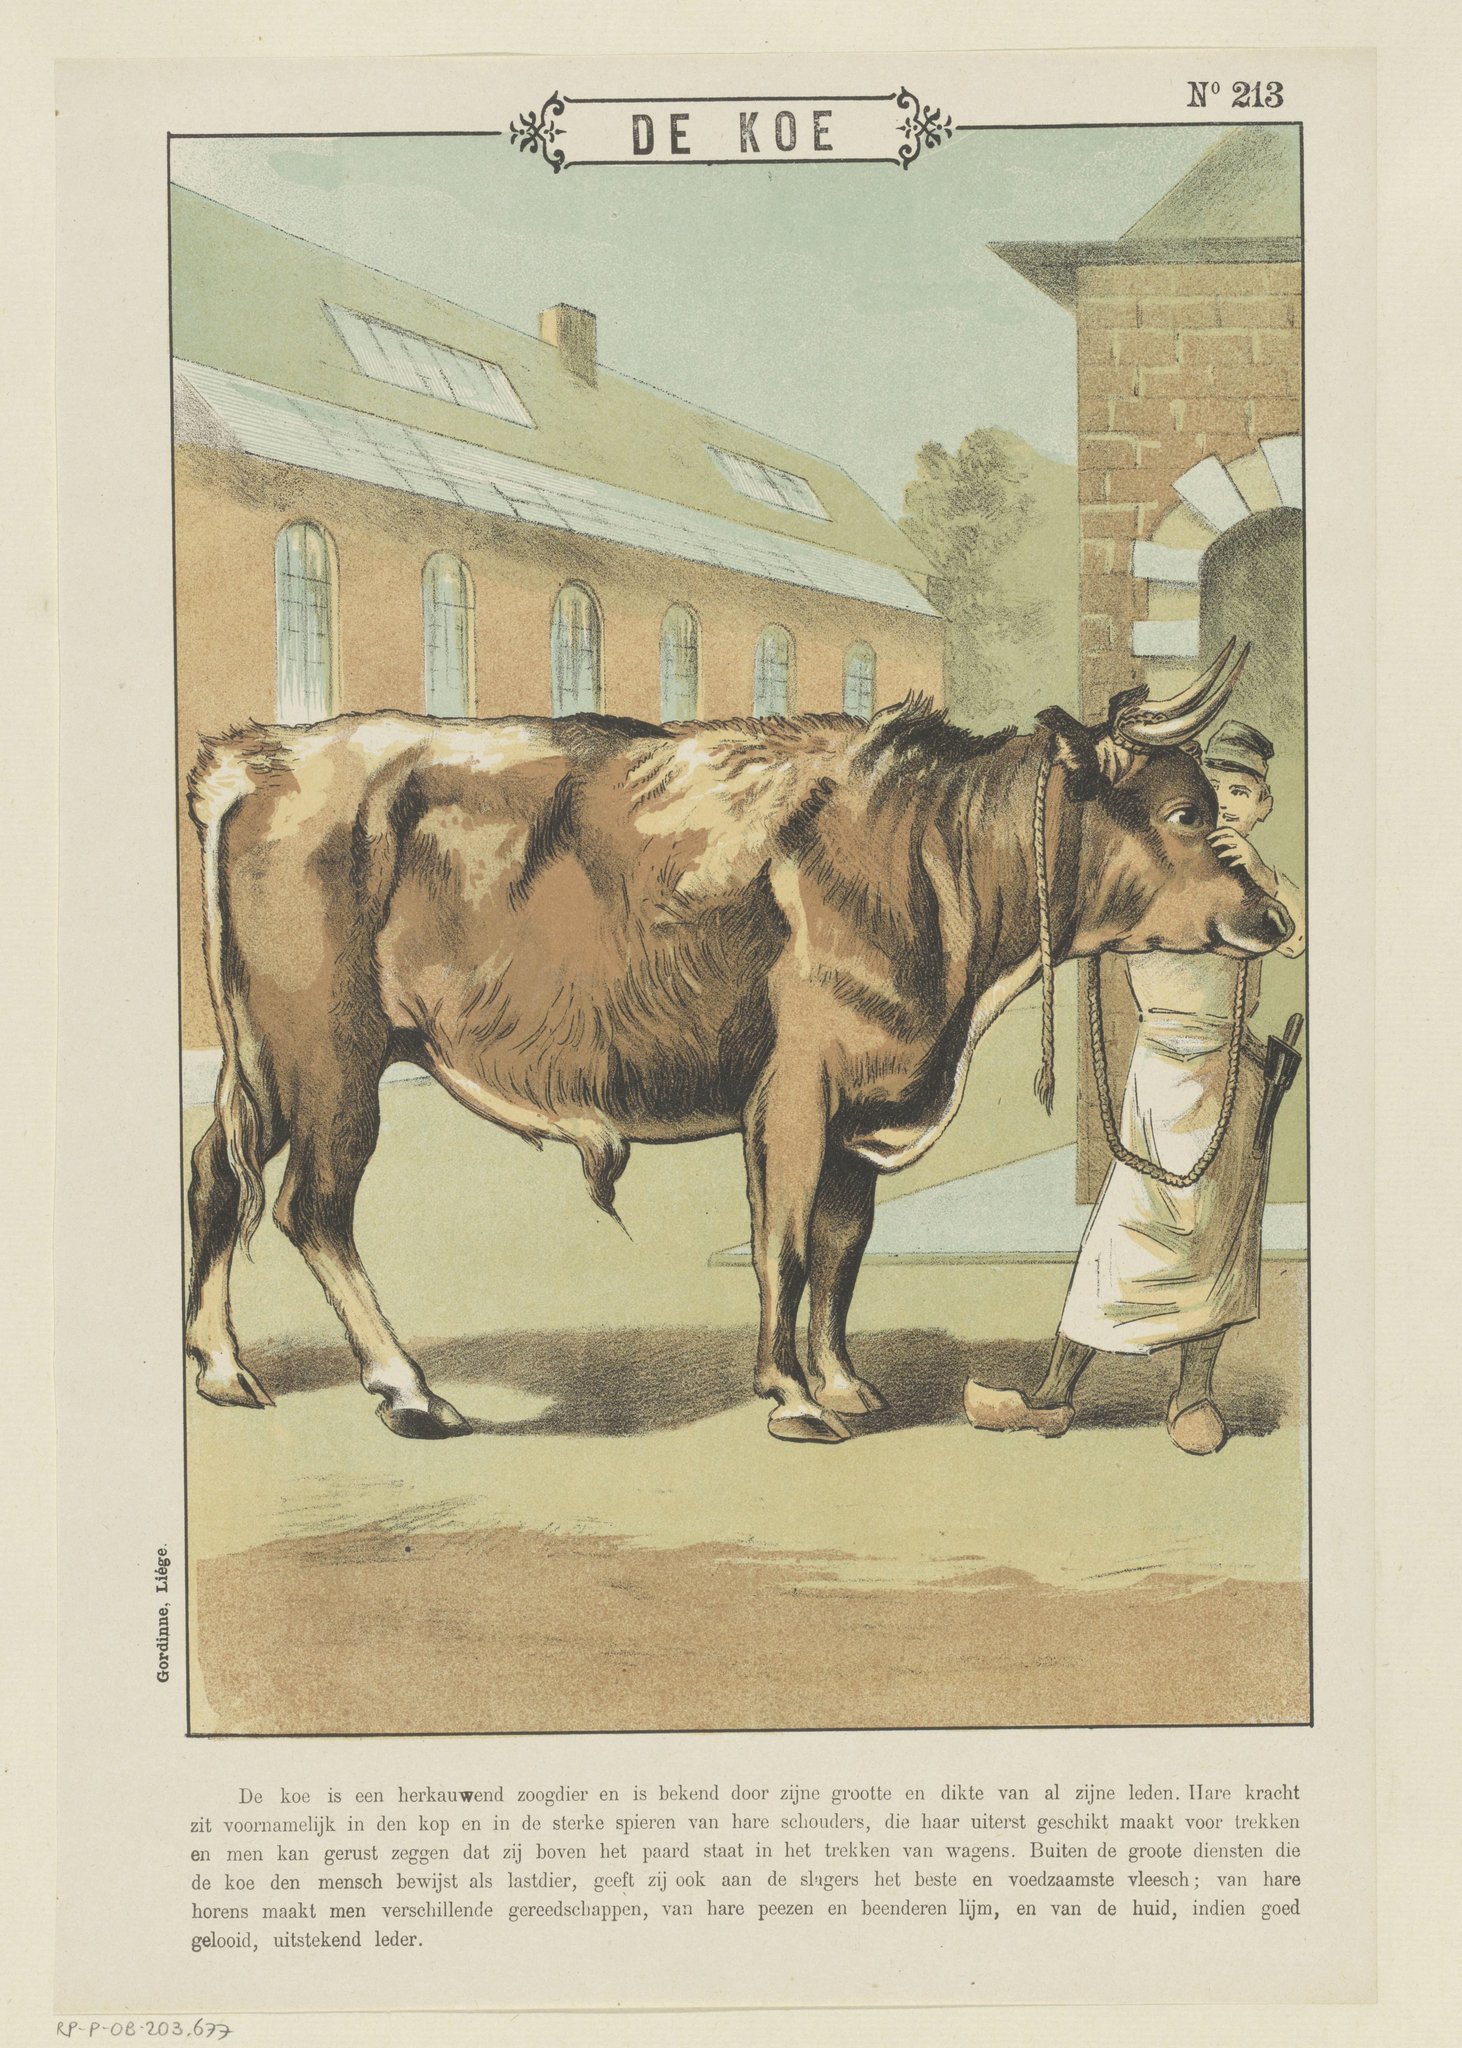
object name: print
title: De koe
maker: Anonymous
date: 1894-1959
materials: paper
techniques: lithograph, letterpress printing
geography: liège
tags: cow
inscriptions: collector's mark: Lugt 2760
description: Blad met een grote voorstelling van een koe. In de ondermarge een onderschrift. Genummerd rechtsboven: No 213.